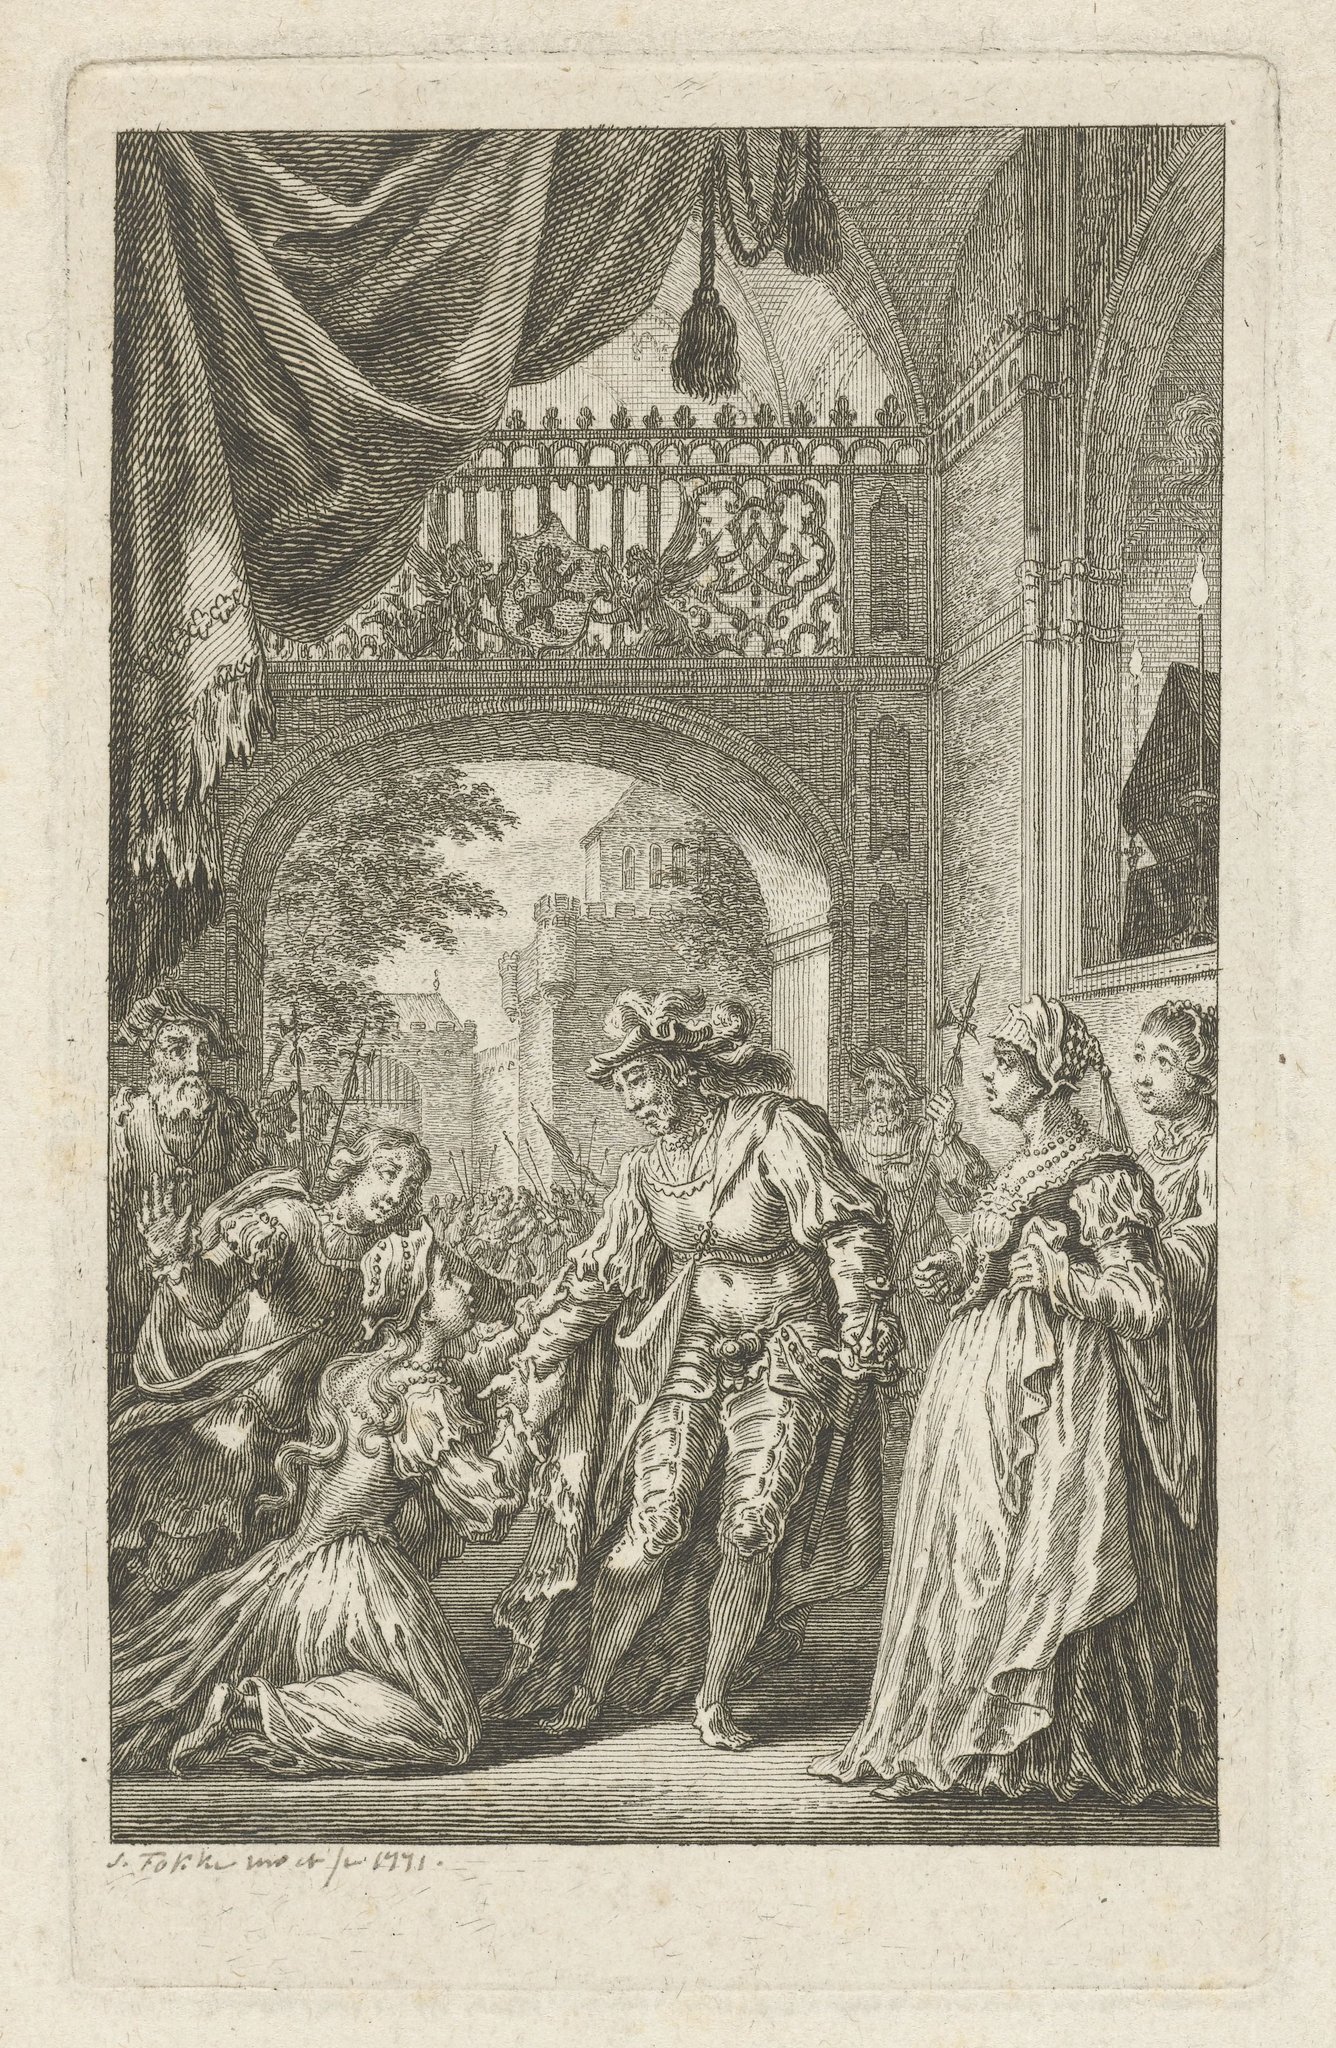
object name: print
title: Ada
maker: simon fokke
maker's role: draughtsman, print maker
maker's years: 1712-1784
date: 1771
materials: paper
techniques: etching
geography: amsterdam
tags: tragedy, kneeling on both knees - aa - female human figure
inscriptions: collector's mark: Lugt 2760, collector's mark: Lugt 2228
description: Een edelvrouw knielt voor een graaf en heeft zijn hand vastgepakt. Drie vrouwen en een man staan om hen heen en slaan het tafereel gade. Deze prent is vervaardigd voor het treurspel "Ada, gravin van Holland en Zeeland" (1765) door F. van Steenwijk.